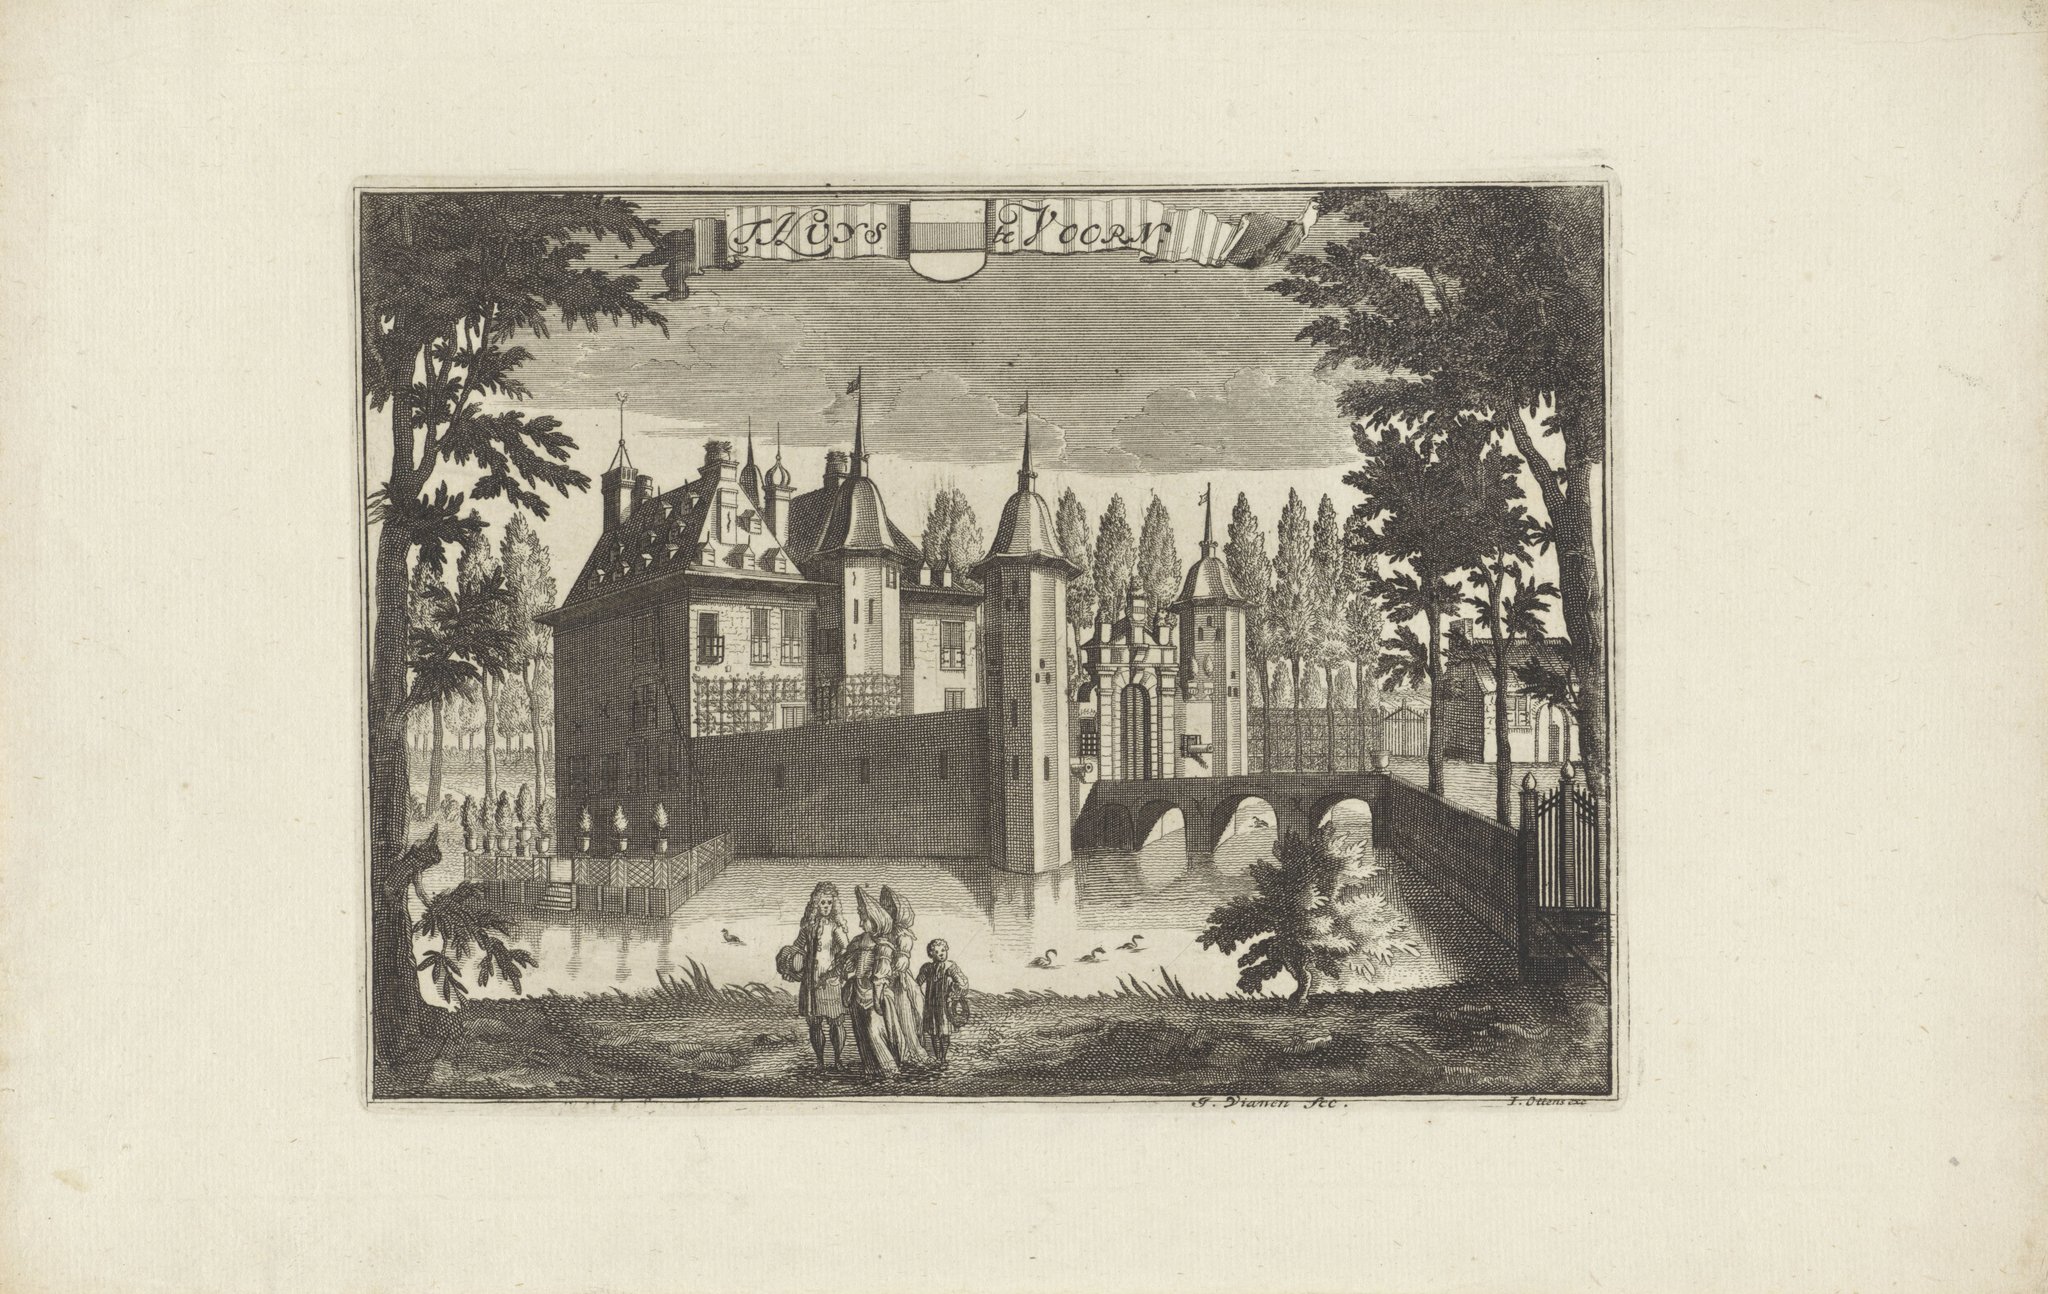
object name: print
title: 'T Huys te Voorn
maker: jan van vianen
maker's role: print maker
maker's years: 1660-1726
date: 1698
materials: paper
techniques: engraving, etching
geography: amsterdam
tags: castle, huis te voorn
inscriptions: collector's mark: Lugt 2228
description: Eerste staat prent gebruikt in: Specht, Caspar. De ridder-matige huysen en gesighten jn de provincie van Utrecht. Utrecht: C. Specht, 1698. Tweede staat prent (volgens Hollstein) gebruikt als boekillustratie in: Specht, Caspar. Het verheerlykt Utrecht vertoont in de afbeeldingen der adelijke en riddermatige hofteden, in de heerlijkheid van Utrecht. Amsterdam: Reinier en Josua Ottens, s.a.